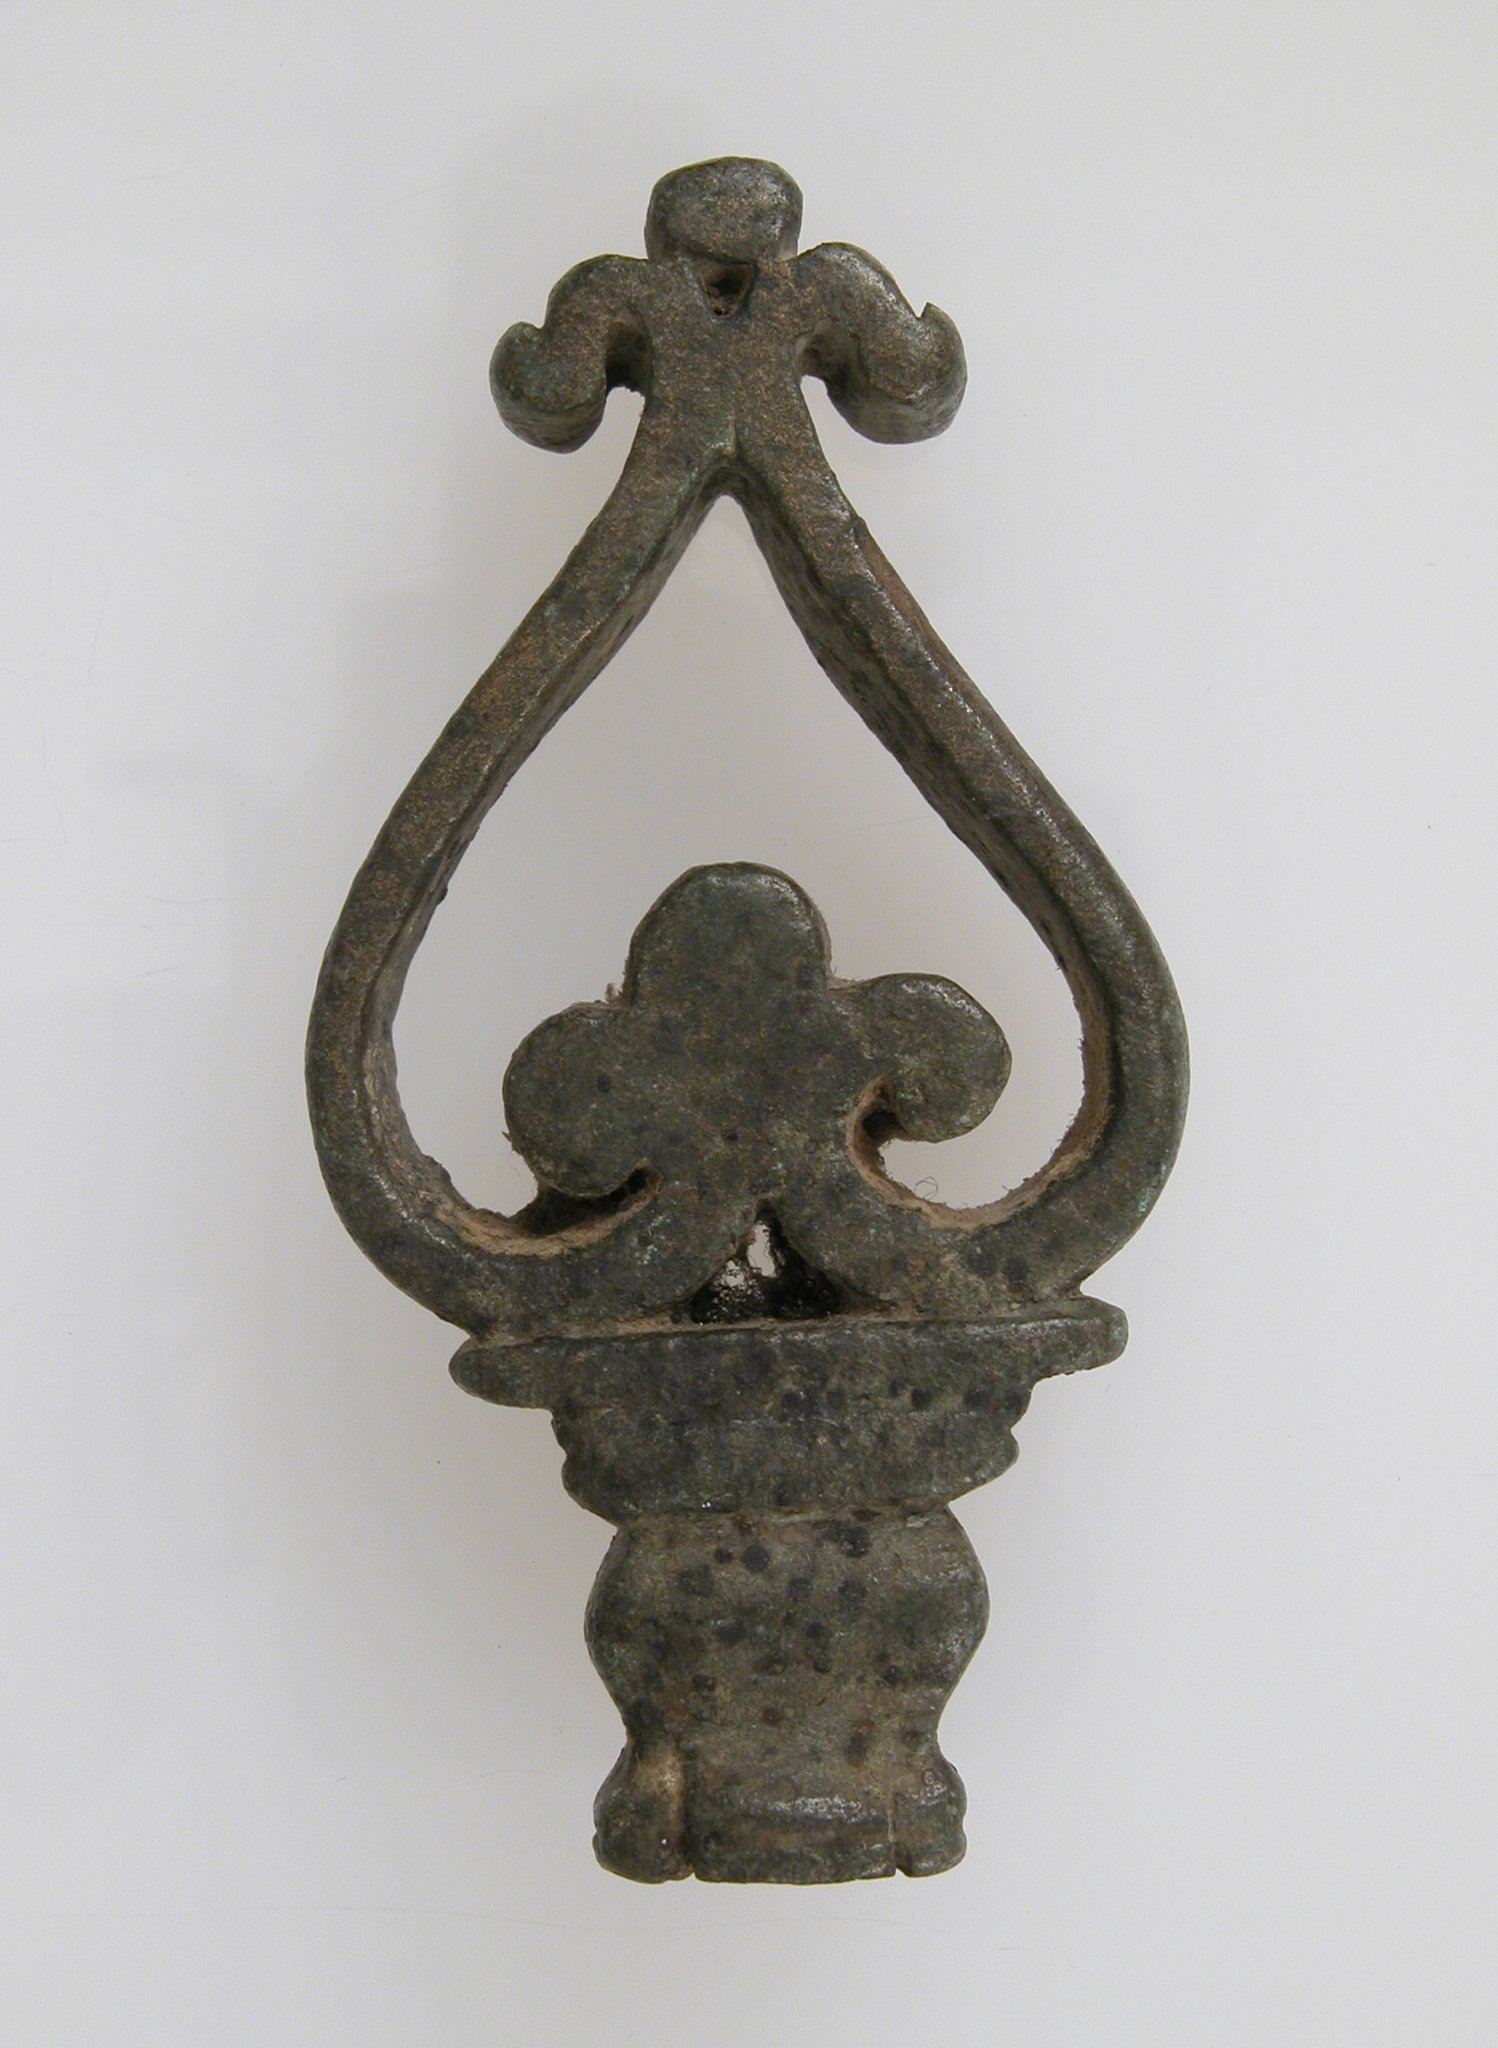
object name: key handle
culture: roman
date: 1-700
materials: copper alloy